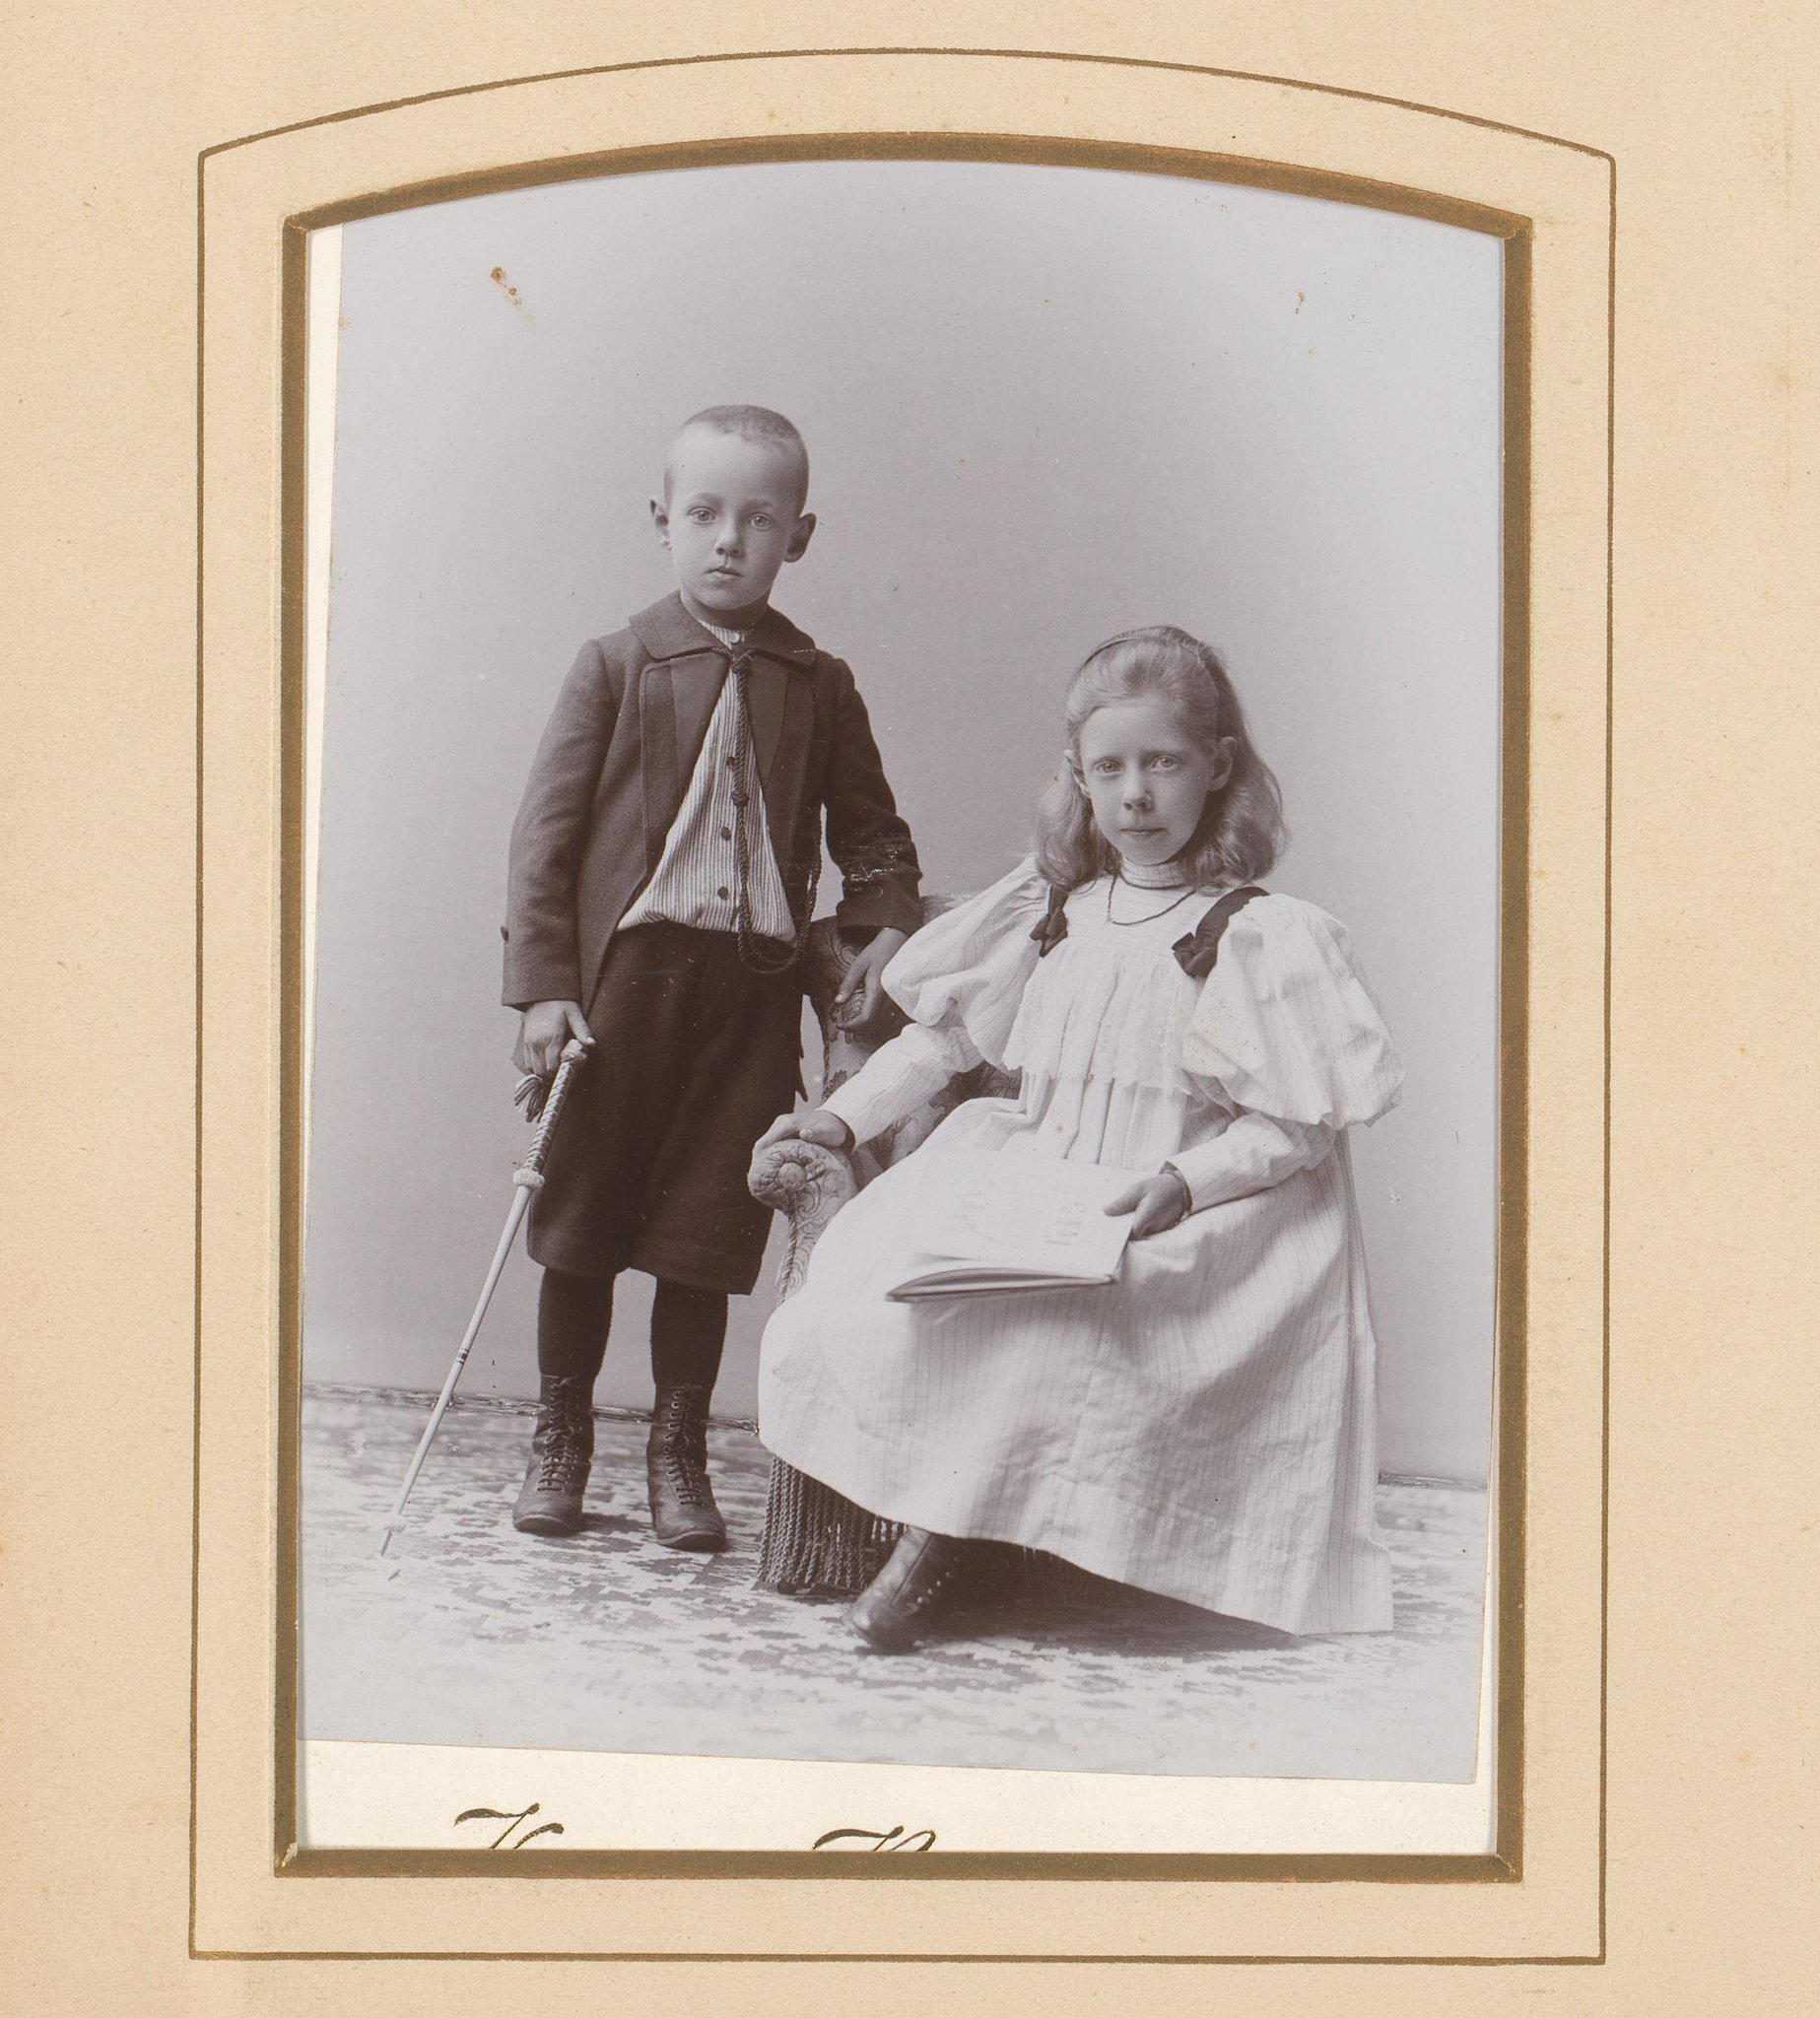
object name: photograph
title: Portret van een zittend meisje met schrift in de hand en een staande jongen met staf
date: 1894-1907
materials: cardboard, photographic support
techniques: collodion silver print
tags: boy (child between toddler and youth), walking-stick, staff, historical persons, girl (child between toddler and youth), book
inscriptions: inscription: ‘Koene & Büttinghausen/ Amsterdam/ Heerengracht 150./ Batavia.’